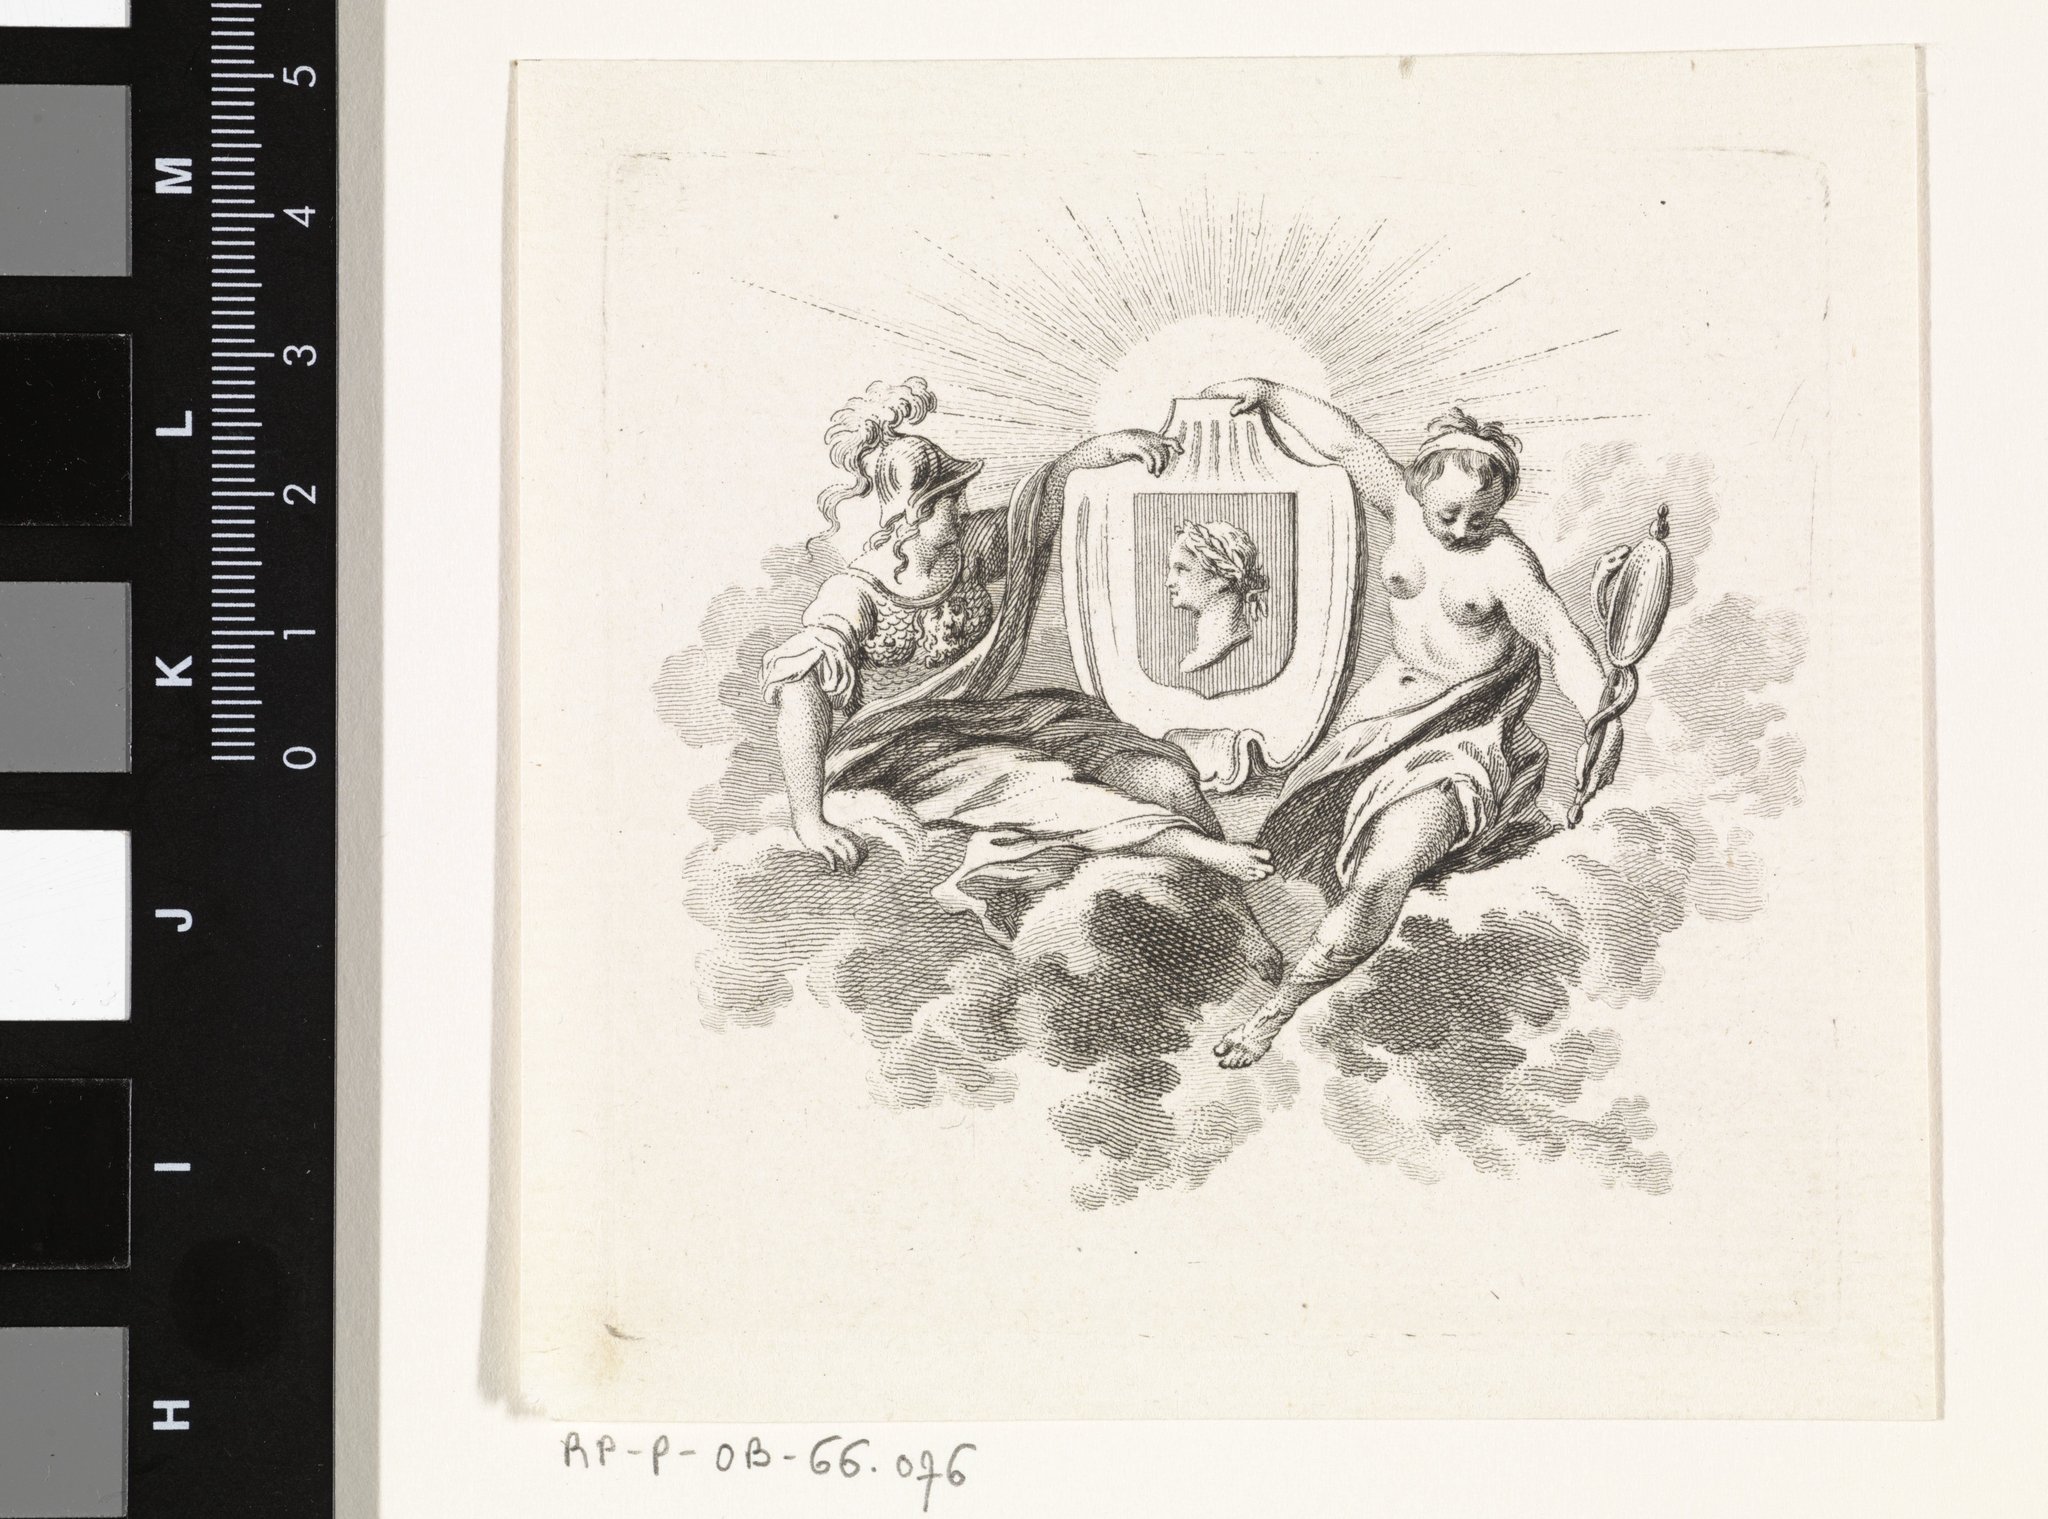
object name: print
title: Wapen van Hendrik Gerritsz. Hooft geflankeerd door Minerva en Voorzichtigheid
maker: reinier vinkeles (i)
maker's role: draughtsman, print maker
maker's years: 1741-1816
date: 1751-1816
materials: paper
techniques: engraving, etching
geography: amsterdam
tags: (story of) minerva (pallas, athena), armorial bearing, heraldry, prudentia (prudence) as roman personification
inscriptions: collector's mark: Lugt 240